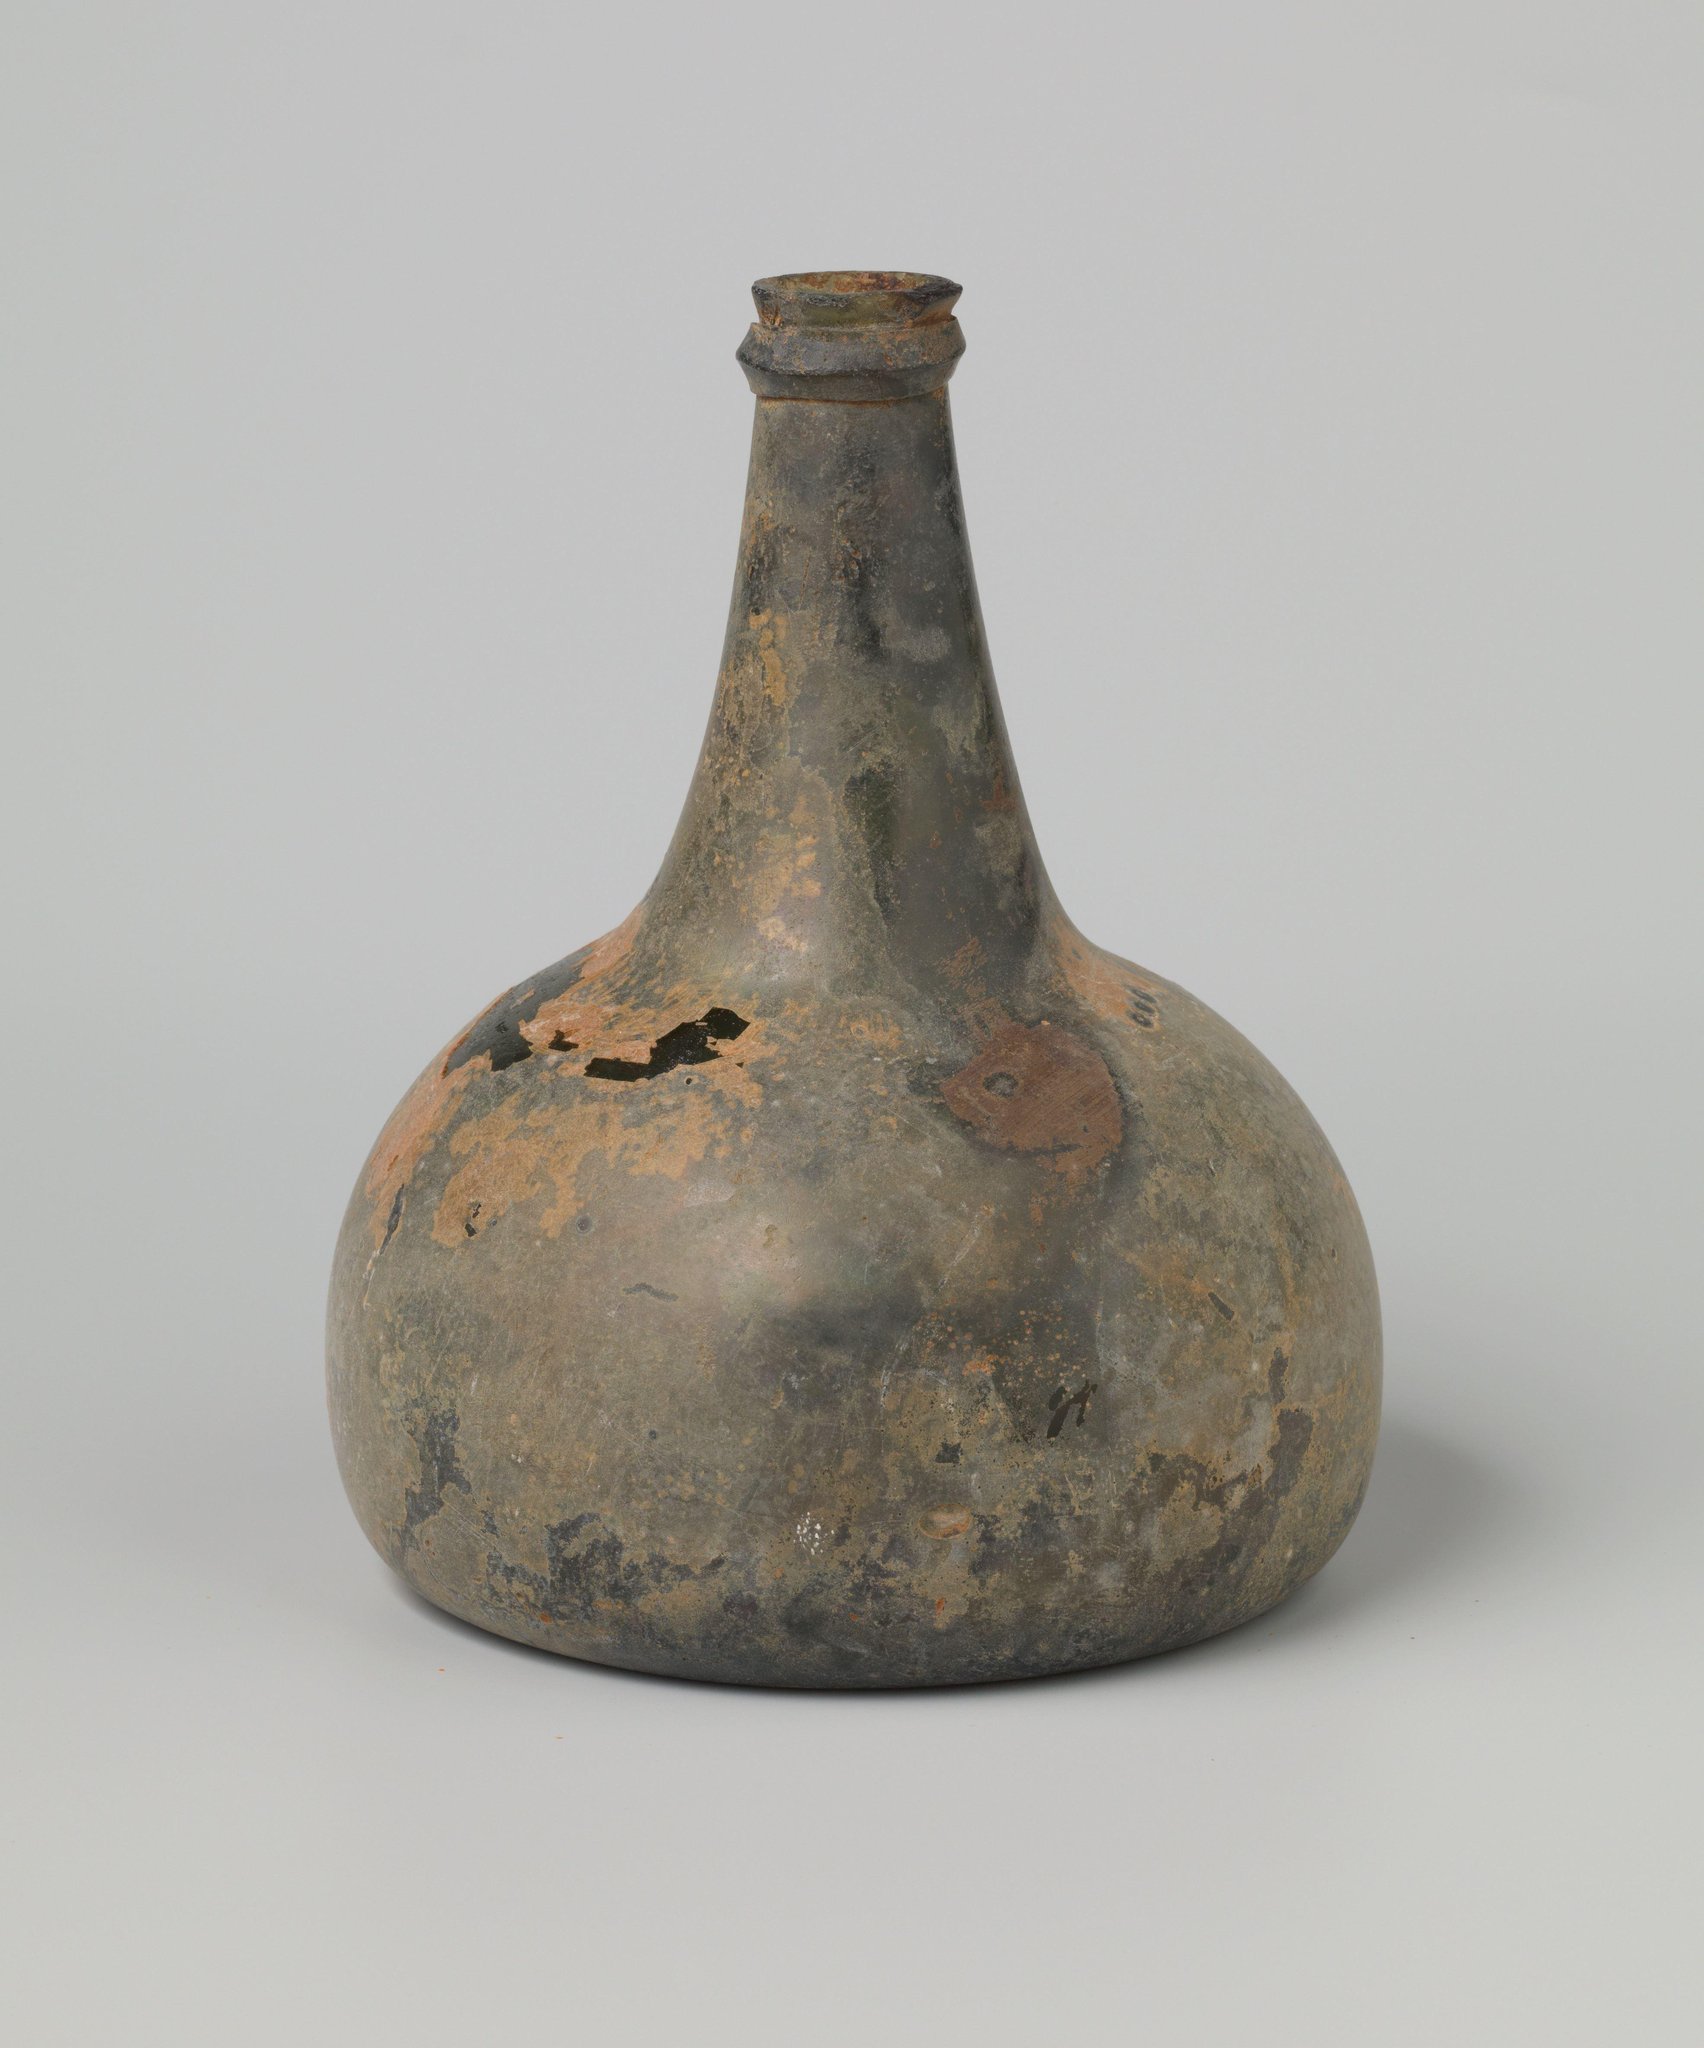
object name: wine bottle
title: Wijnfles uit het wrak van de Oost-Indiëvaarder Hollandia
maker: Anonymous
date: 1700-1743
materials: glass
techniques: green glass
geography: netherlands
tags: verenigde oostindische compagnie, hollandia (schip), annet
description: Wine bottle, continental production, onion-shaped, complete; broad vs-string rim, tcs-kick-up.